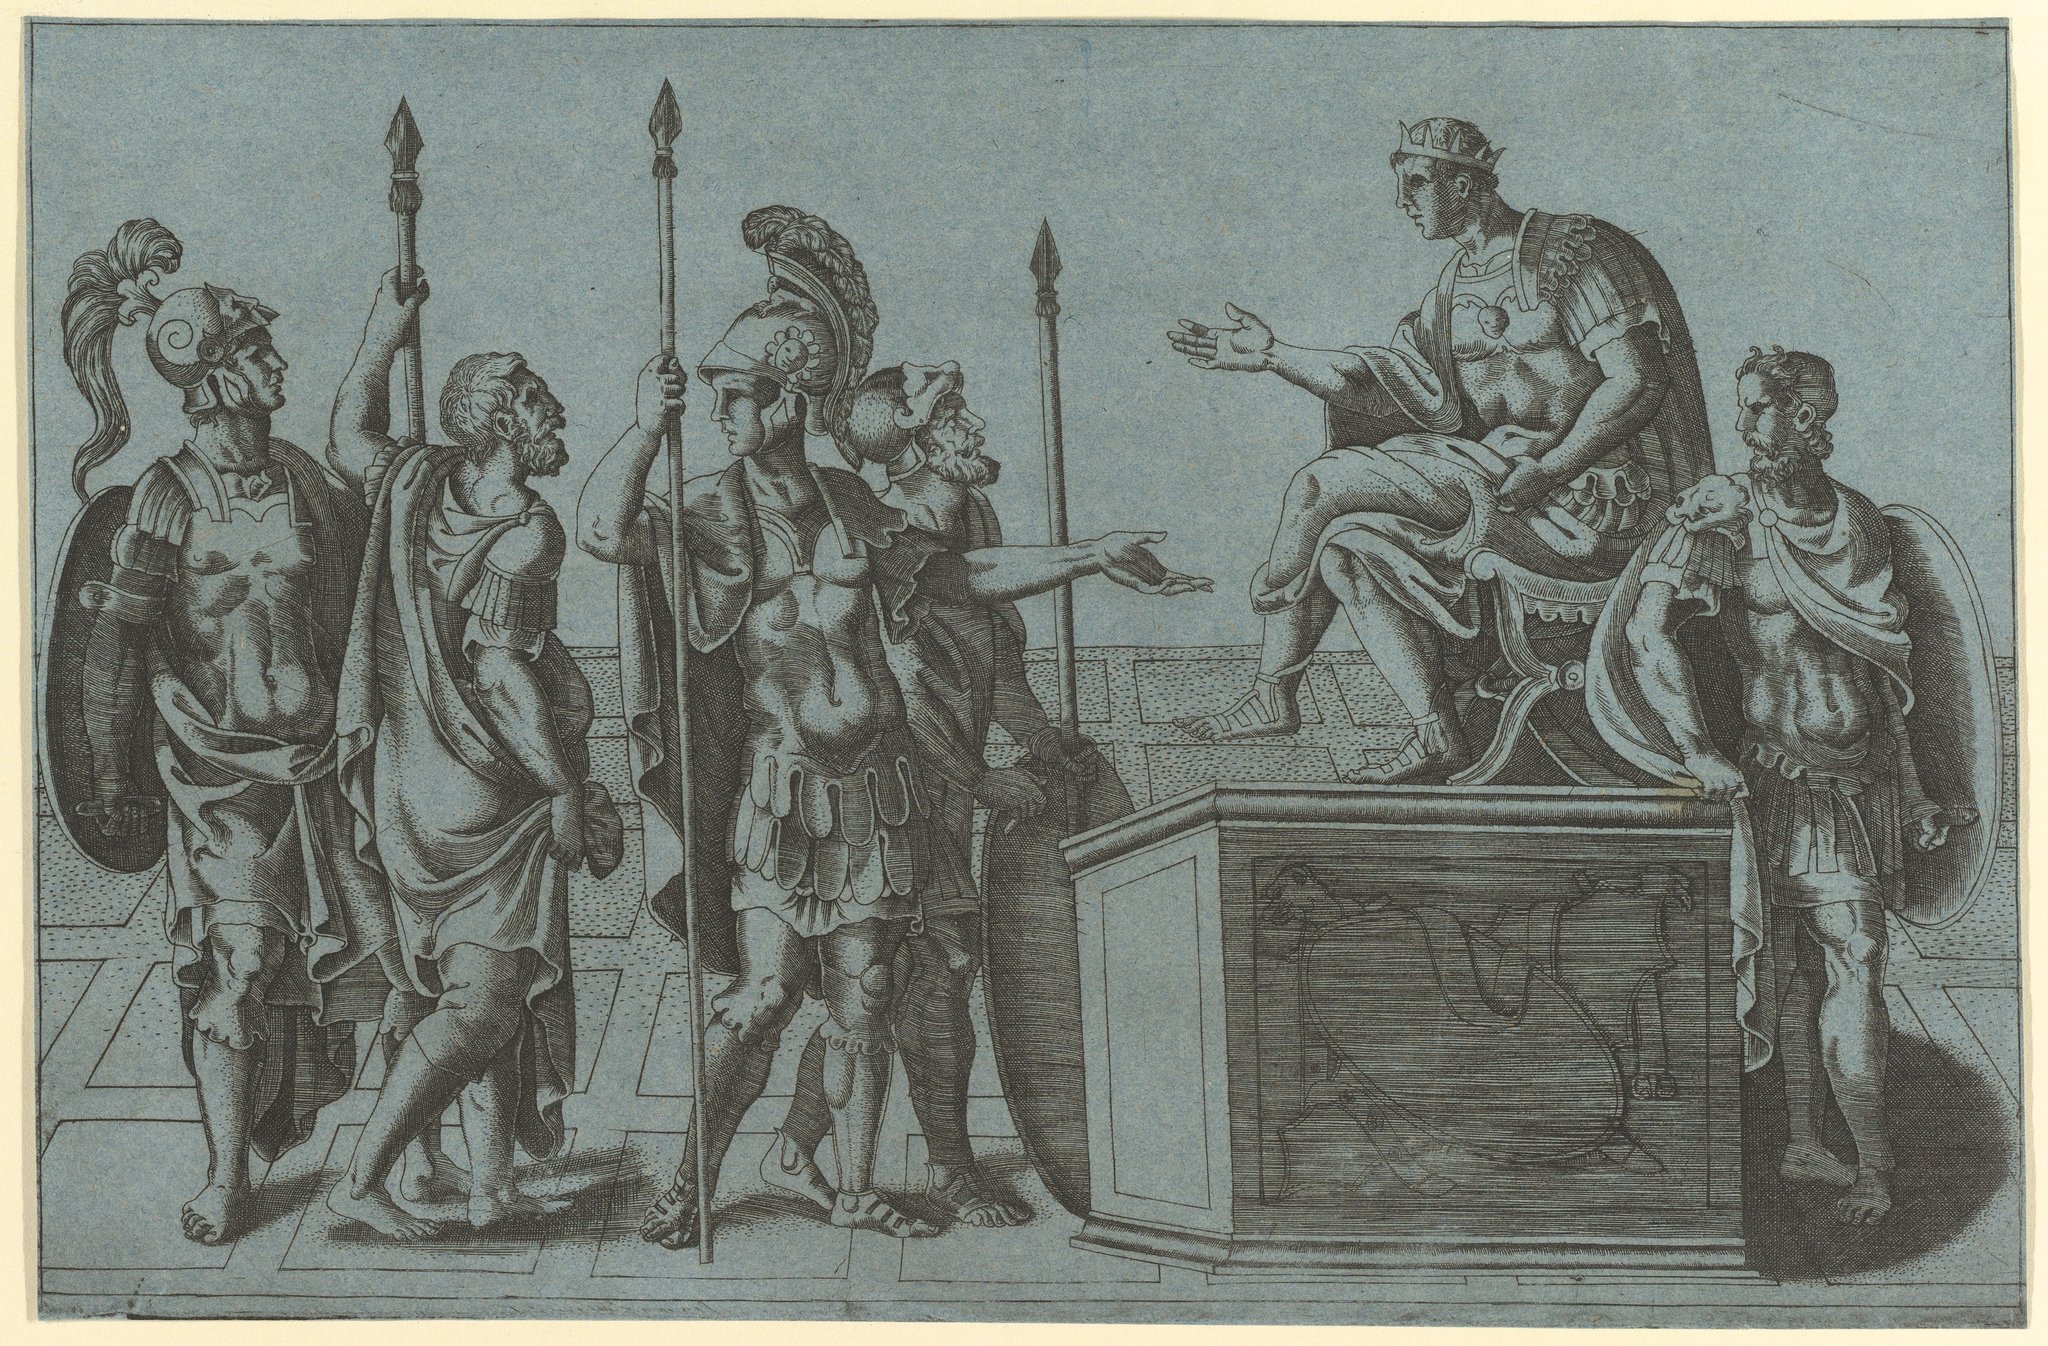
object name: print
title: Roman Soldiers Before an Emperor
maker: giorgio ghisi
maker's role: artist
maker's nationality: italian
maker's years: 1515-1582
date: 1540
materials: paper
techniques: engraving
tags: soldiers,spears,men